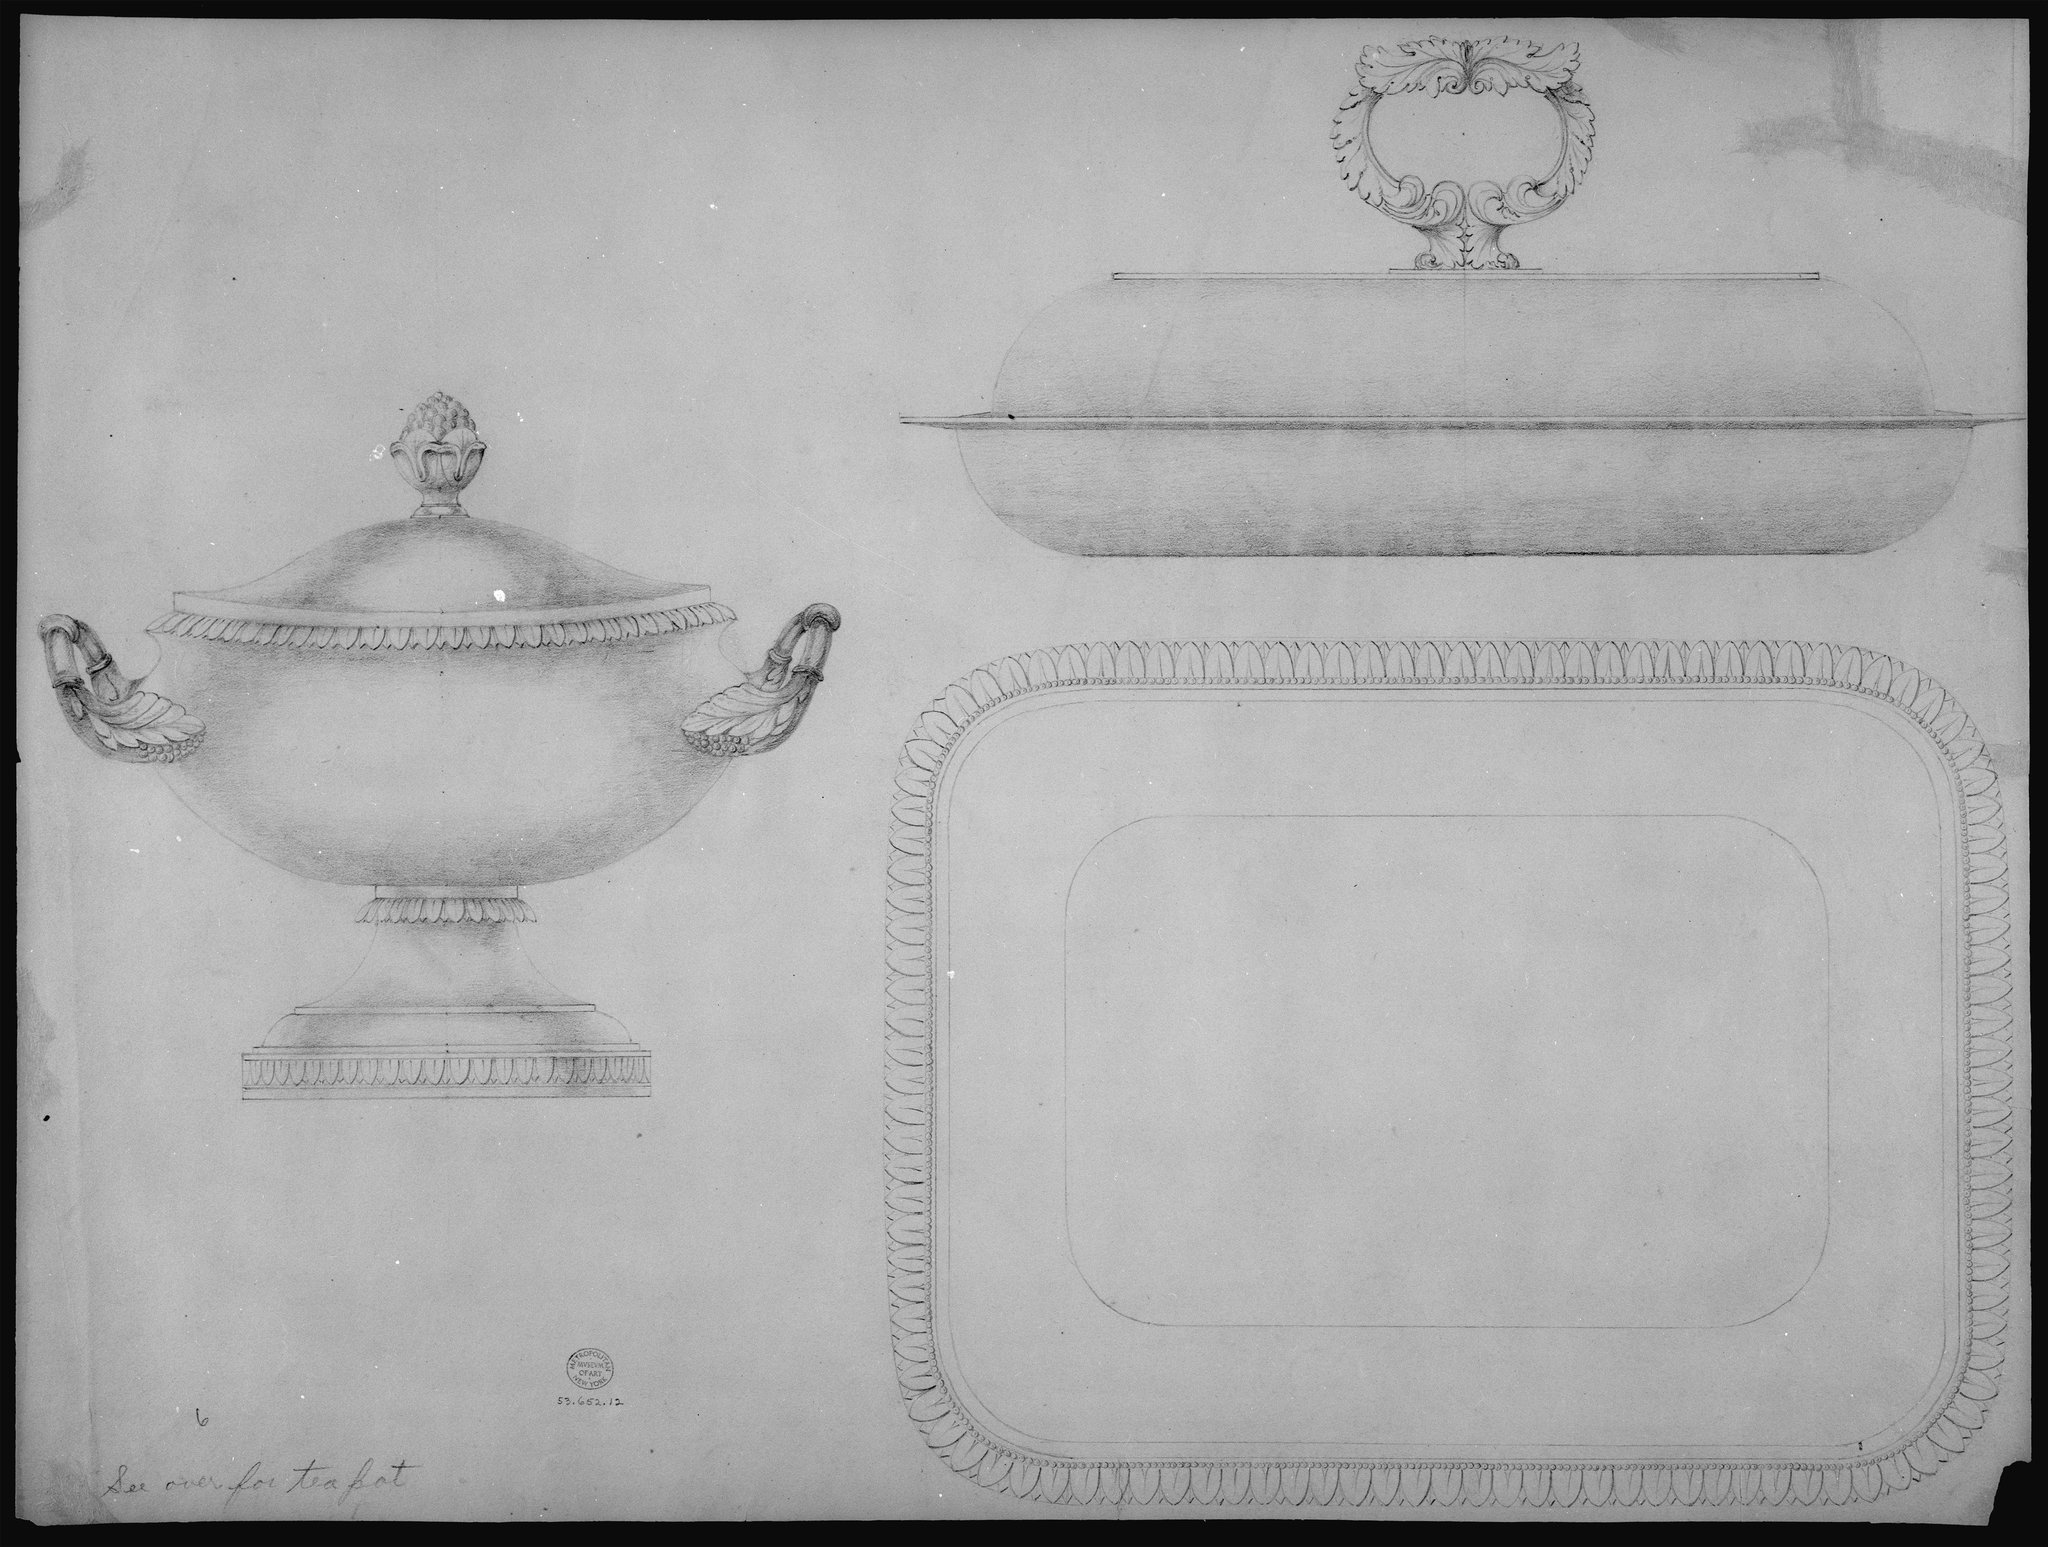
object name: drawing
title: Design for a tea-pot, verso: design for a covered dish and bowl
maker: thomas fletcher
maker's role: artist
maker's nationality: american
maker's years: 1787-1866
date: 1800-1866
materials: graphite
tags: bowls,dishes,teapots